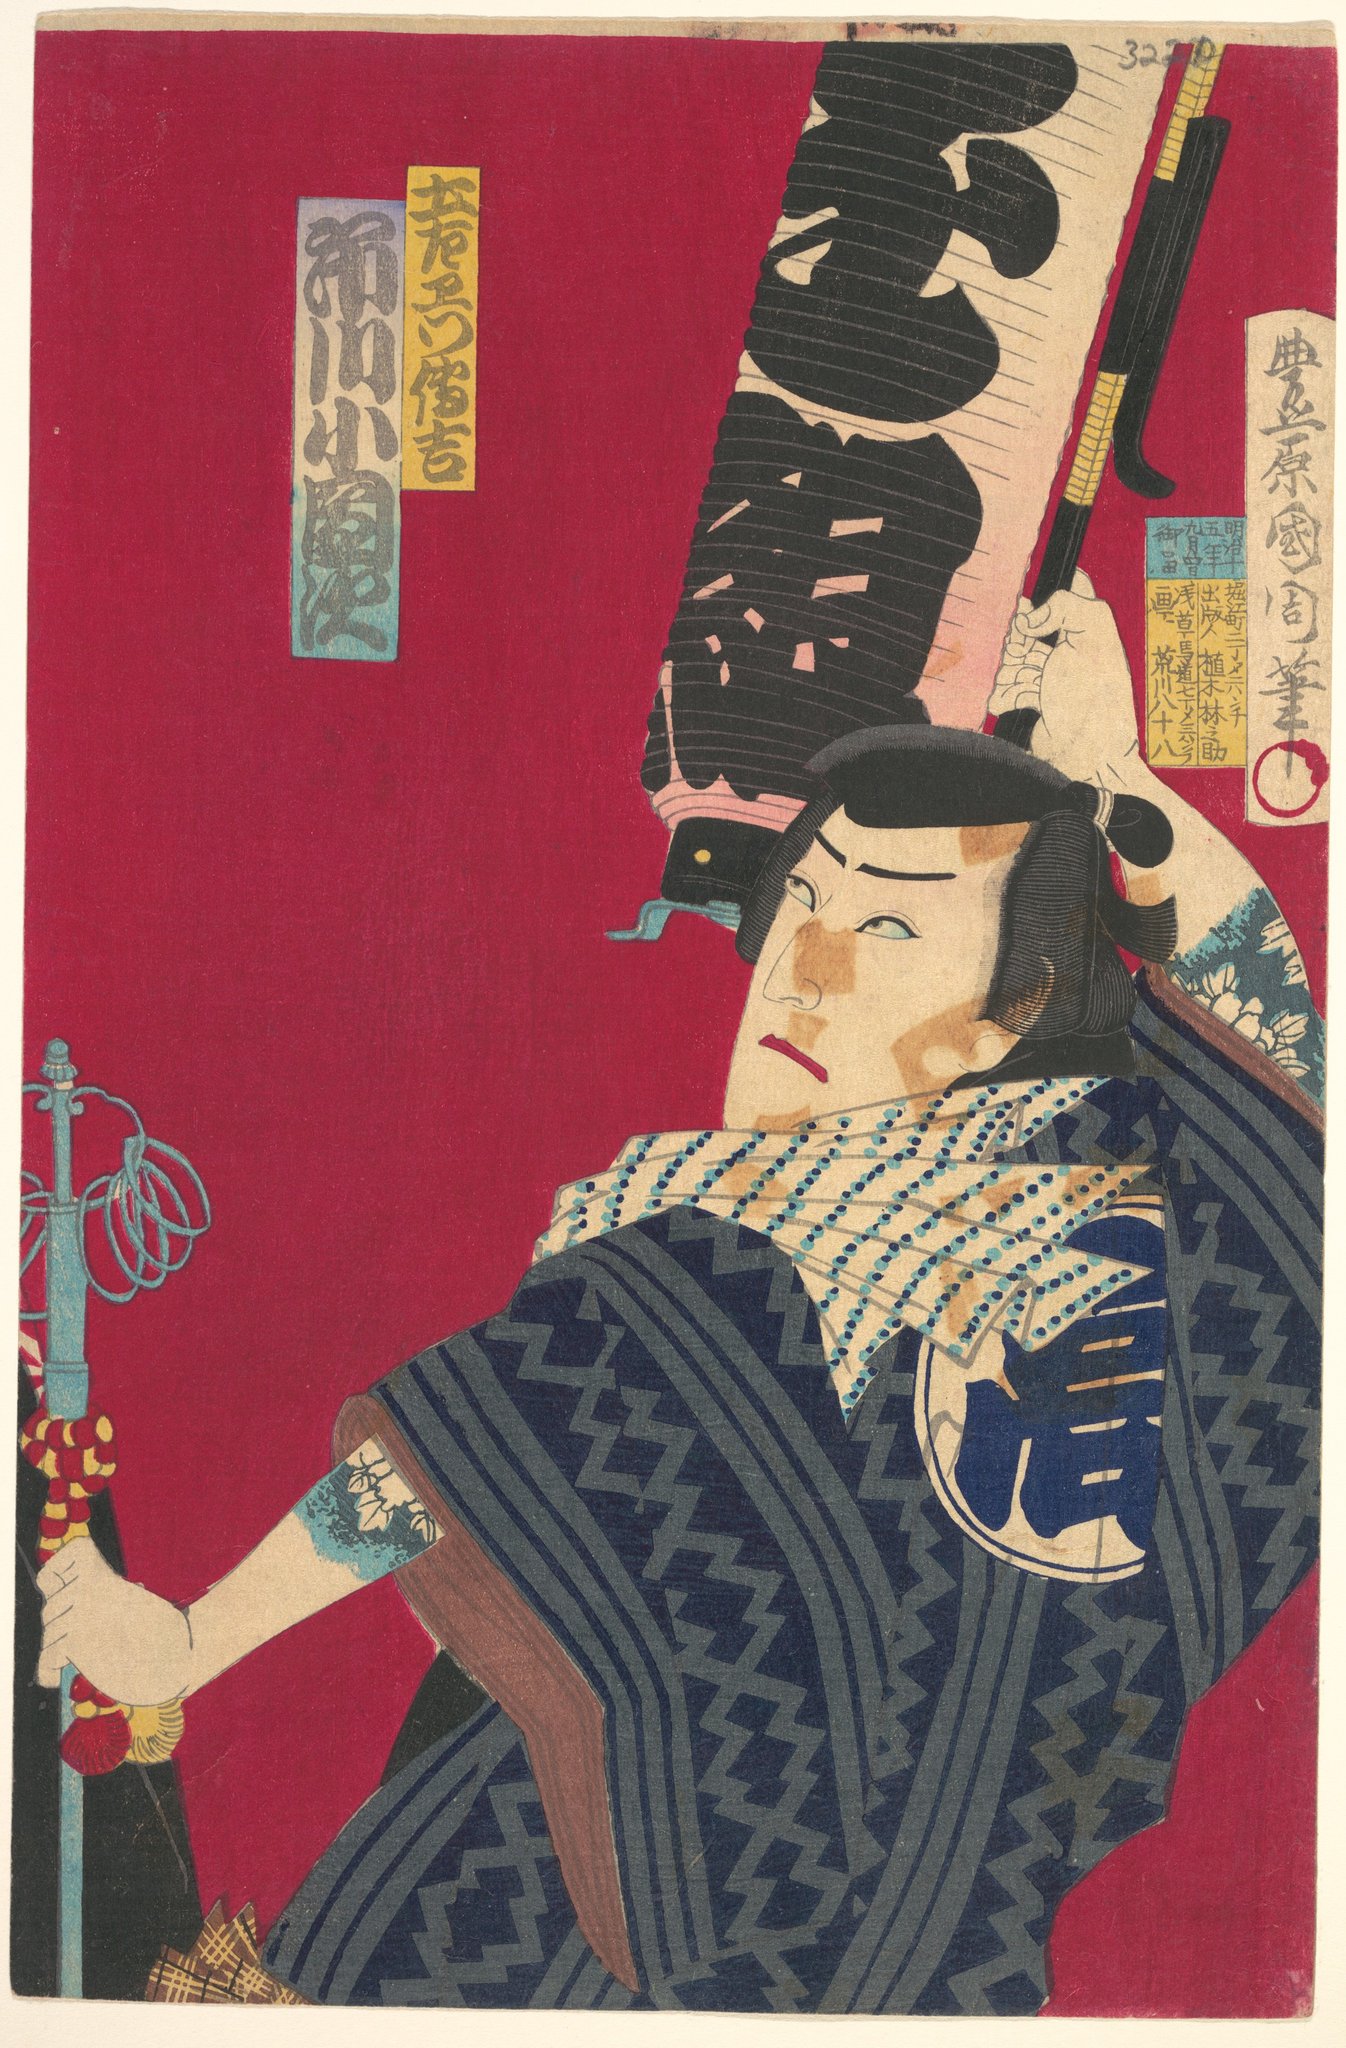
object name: print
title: Ichikawa Sadanji as Dozaemon Denkichi in a Kabuki Play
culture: japanese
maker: toyohara kunichika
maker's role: artist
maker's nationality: japanese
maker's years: 1835-1900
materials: ink, paper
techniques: woodblock print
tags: men,actors,lanterns